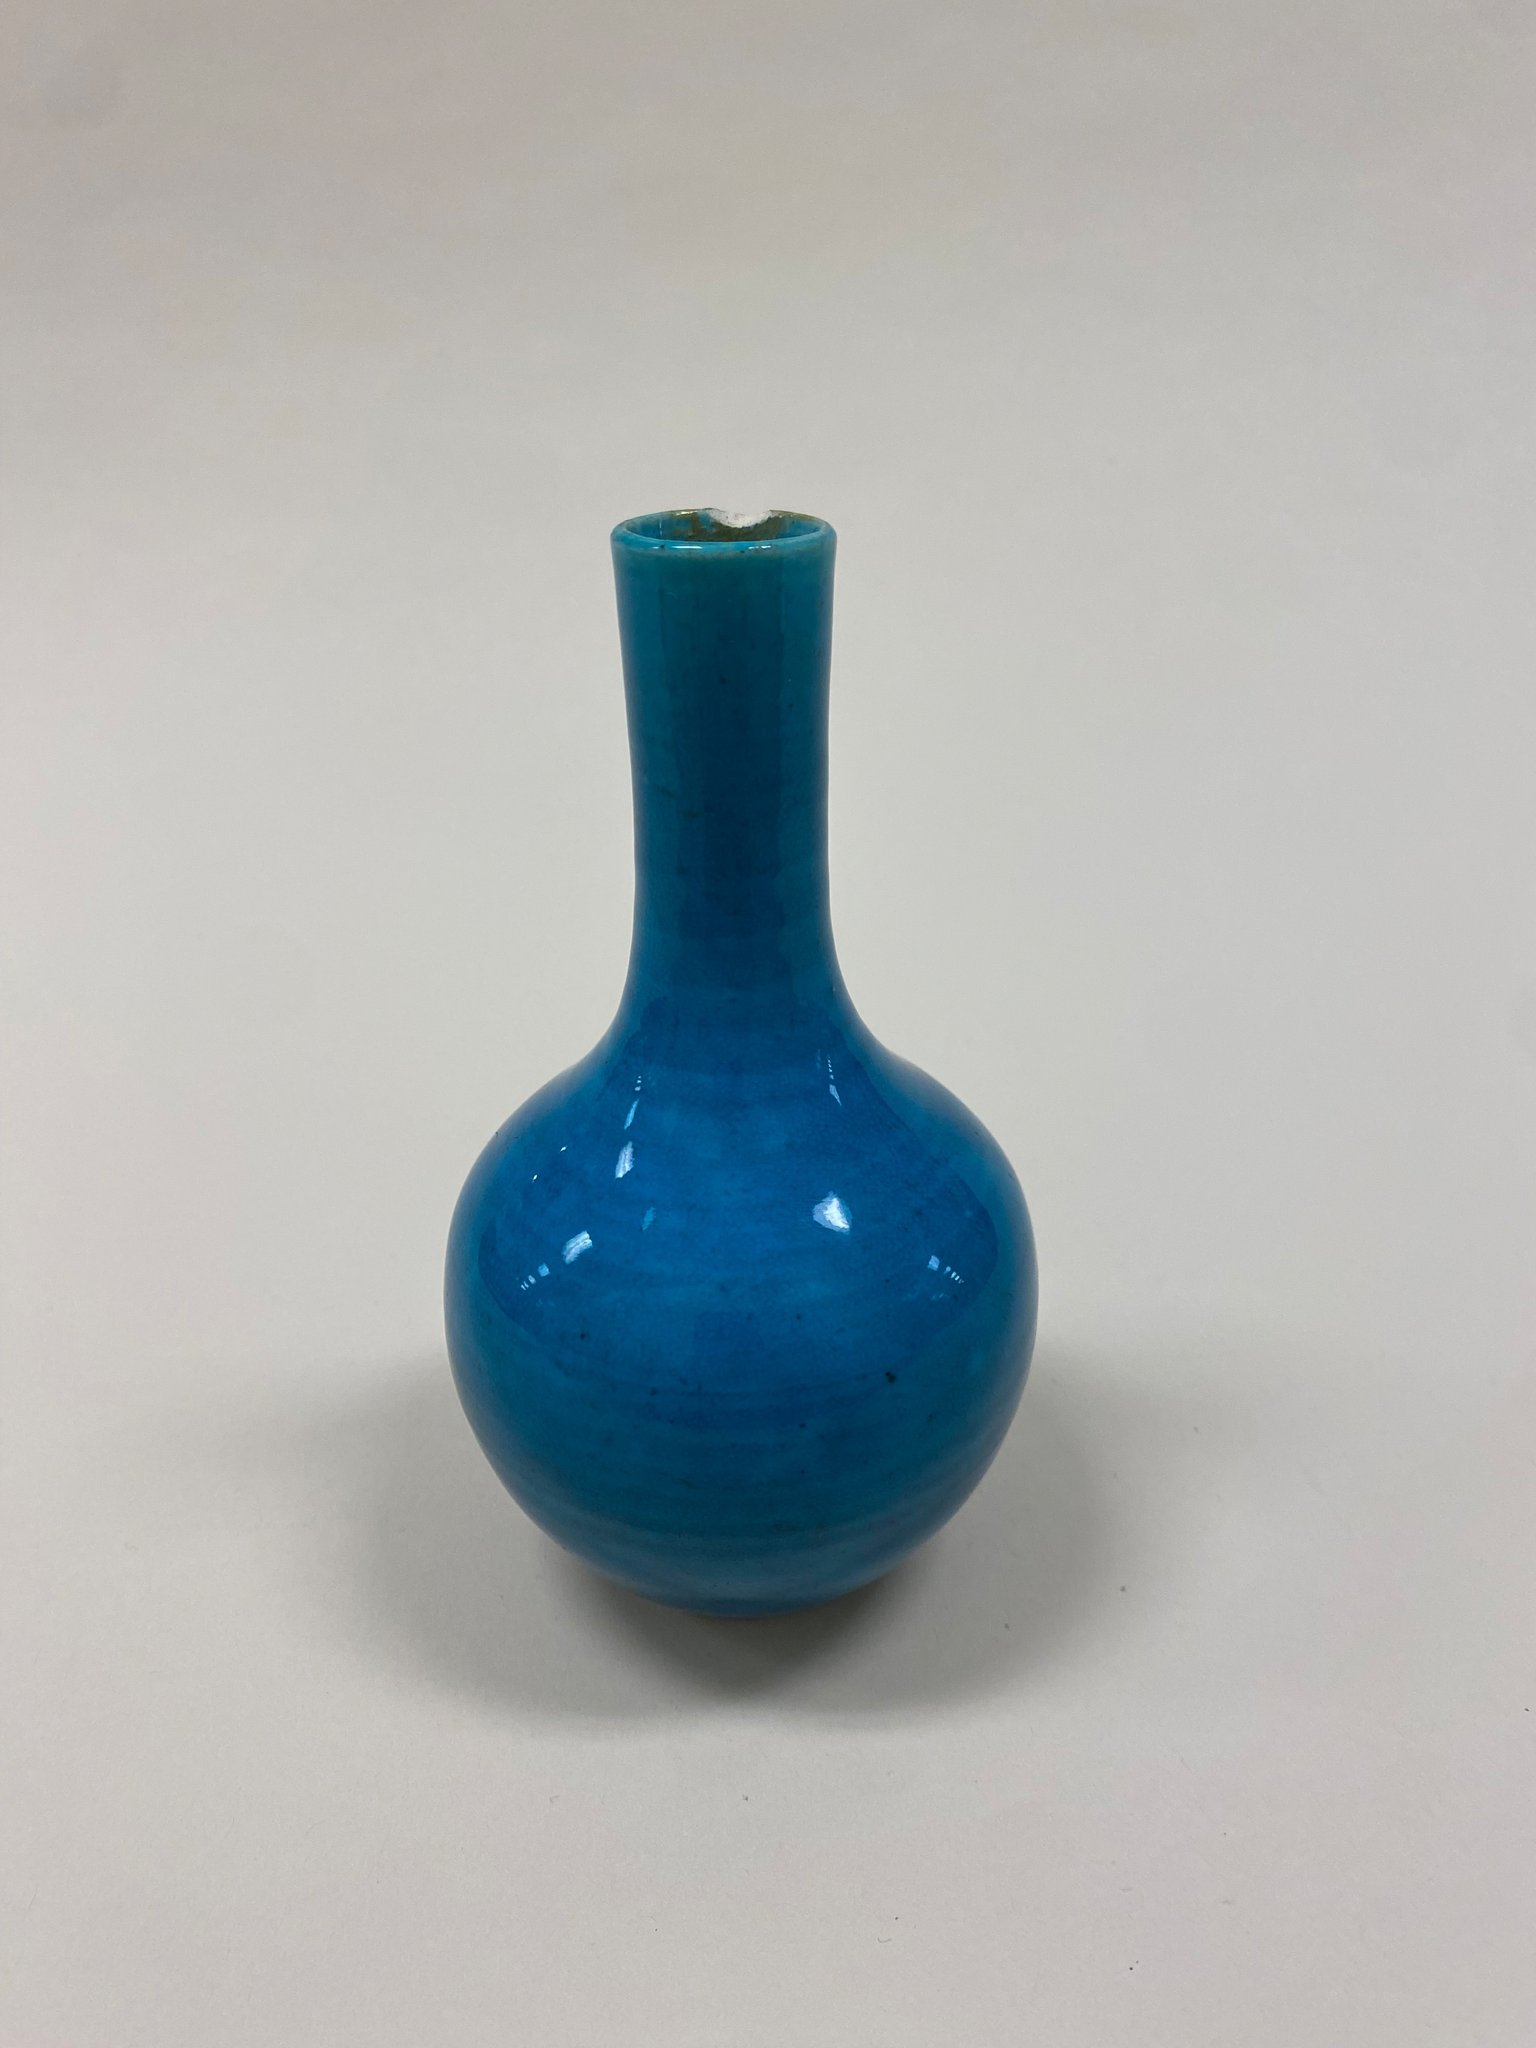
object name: bottle vase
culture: chinese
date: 1701-1800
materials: glaze, porcelain